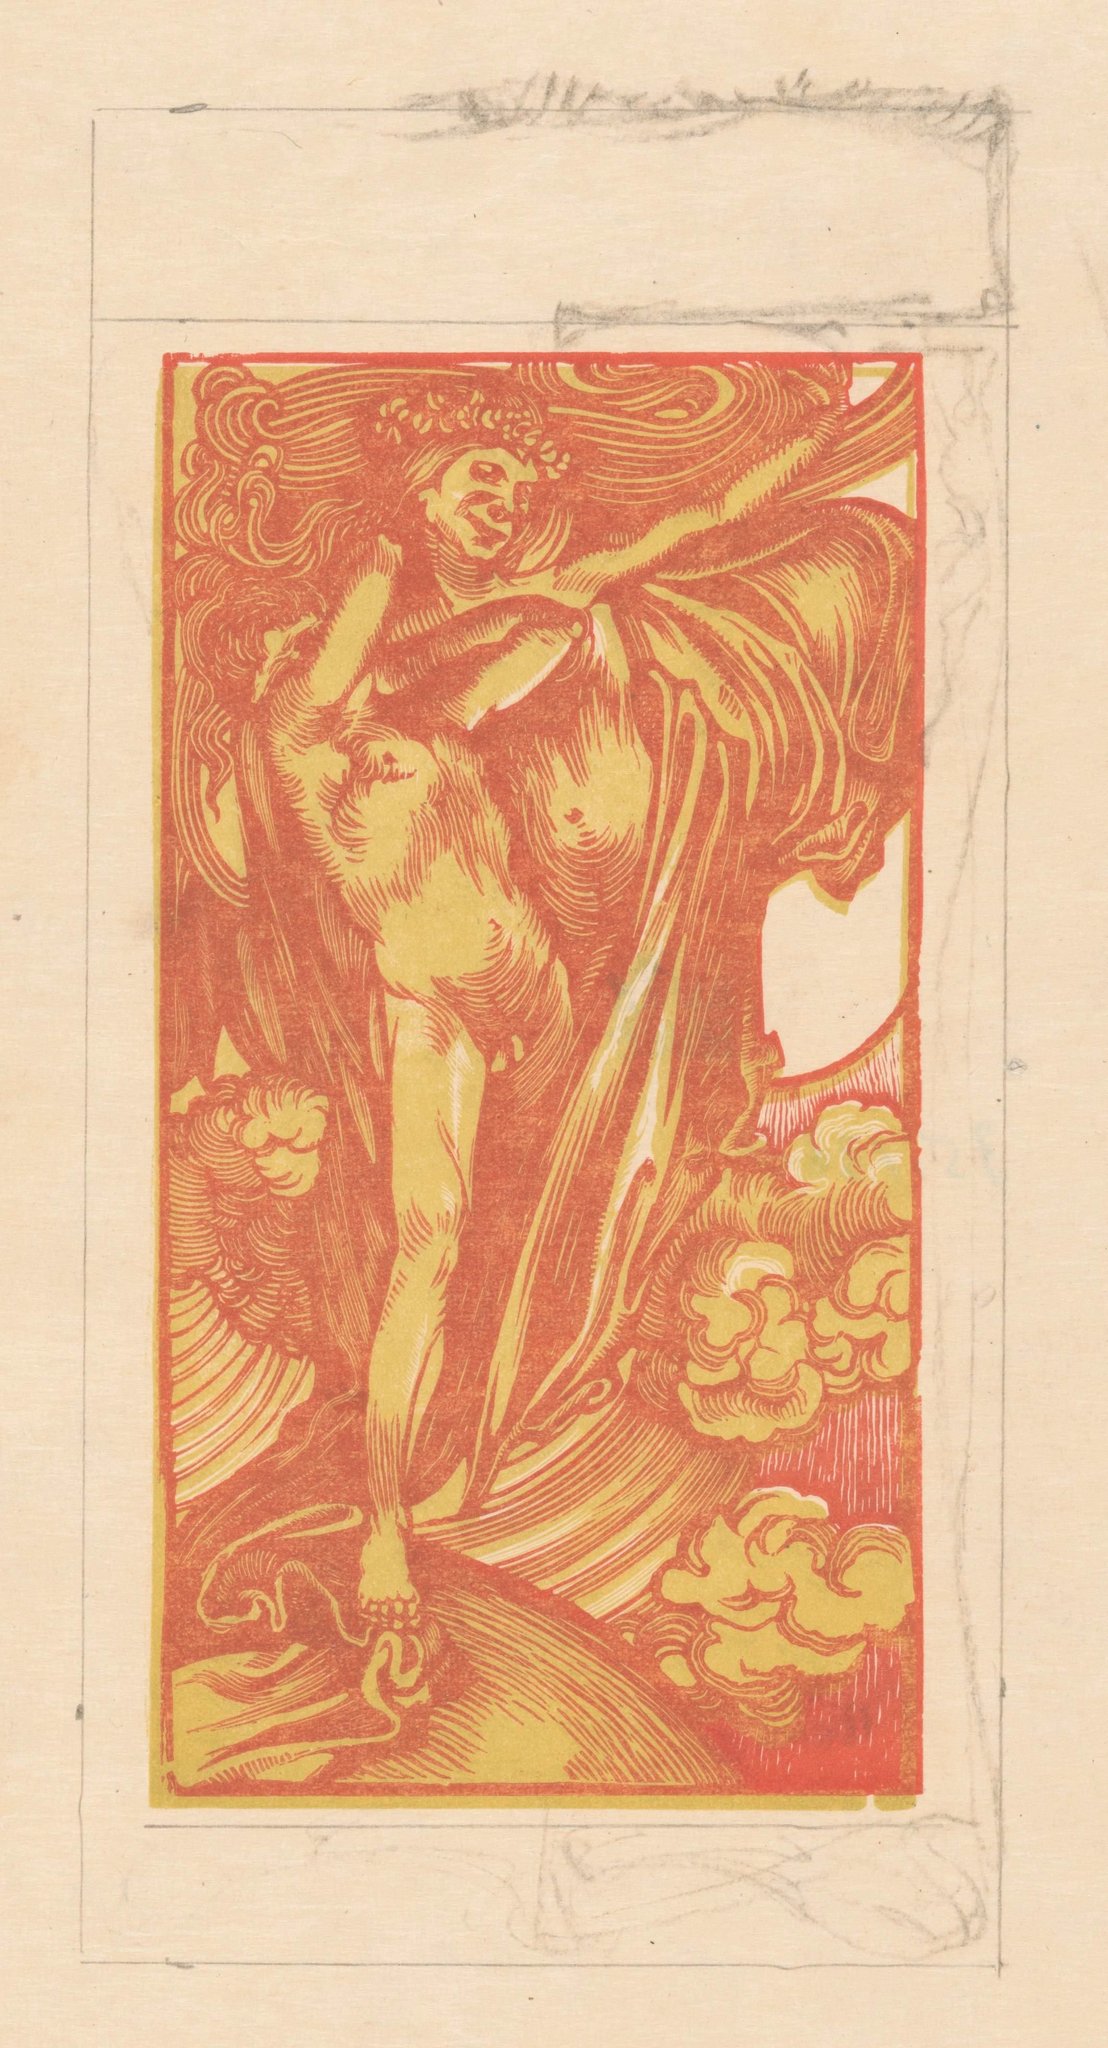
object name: print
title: Vrouw en jongen in de wolken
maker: johannes josephus aarts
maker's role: draughtsman, print maker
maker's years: 1871-1934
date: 1881-1934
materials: paper, pencil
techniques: woodcut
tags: (showing oneself) undressed, quasi-nude, clouds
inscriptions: collector's mark: Lugt 2760, collector's mark: Lugt 2166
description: Een naakte vrouw en jongen, beiden gedeeltelijk bedekt door de mantel van de vrouw. Om hen heen verschillende wolken. De vrouw draagt een bloemenkrans in haar golvende haar, mogelijk stelt ze een genius voor.